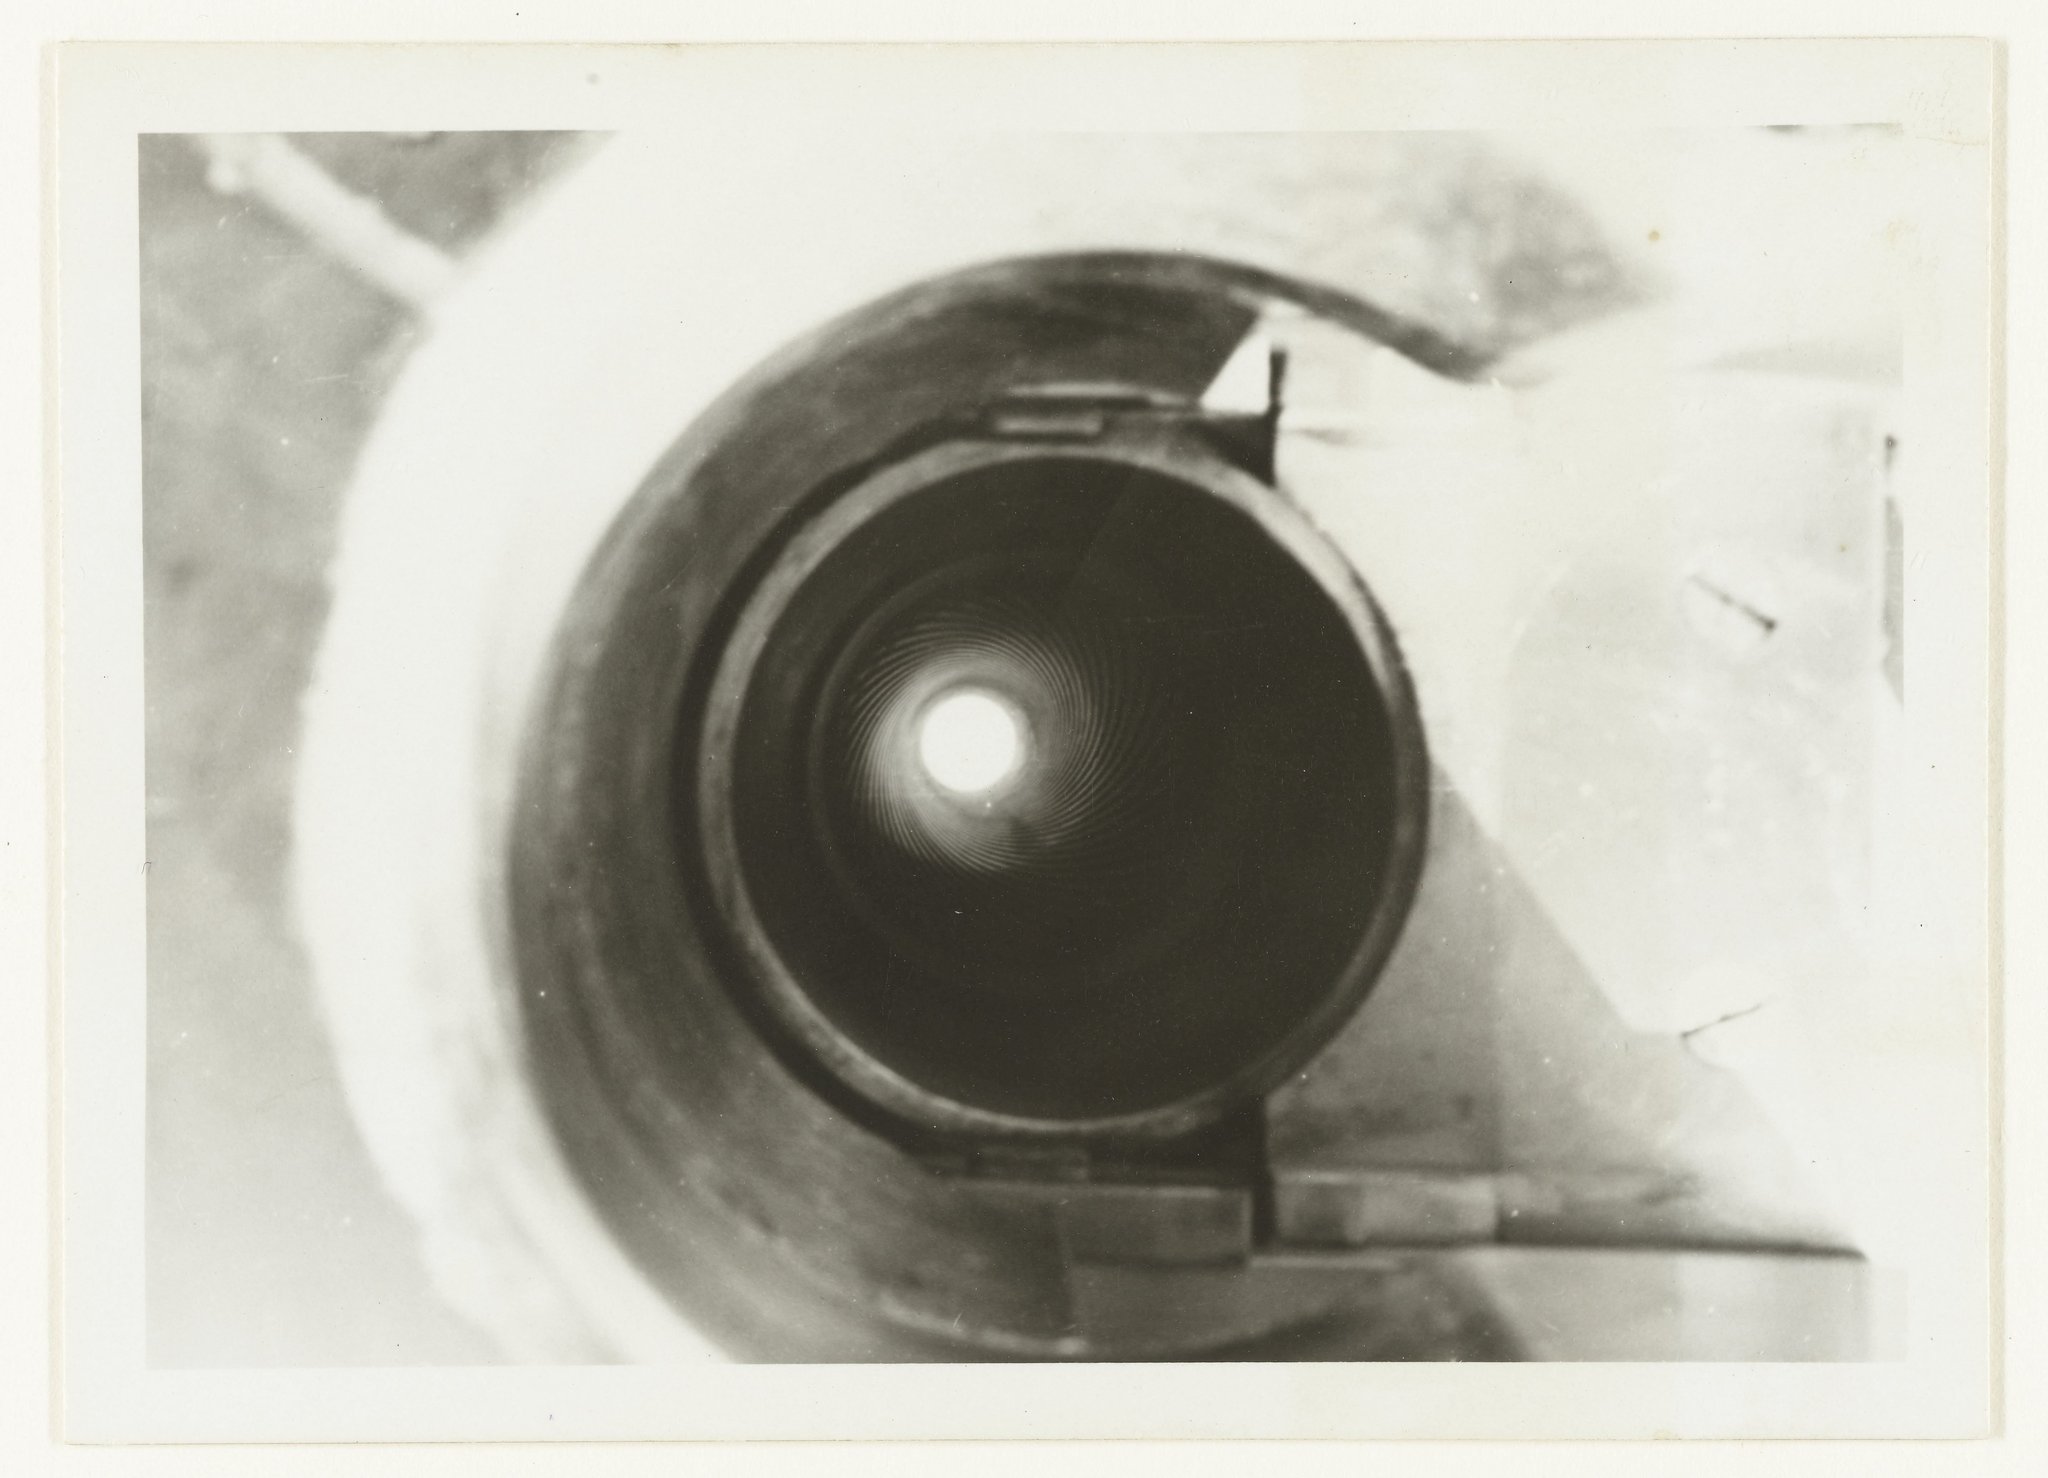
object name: photograph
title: Blik in de loop van een Duits kanon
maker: Anonymous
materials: photographic support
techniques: gelatin silver print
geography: dongen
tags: firearms: cannon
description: Een blik in de loop van een Duits kanon. De foto behoort tot een groep foto’s met de Wehrmacht in bezet Nederland als onderwerp.